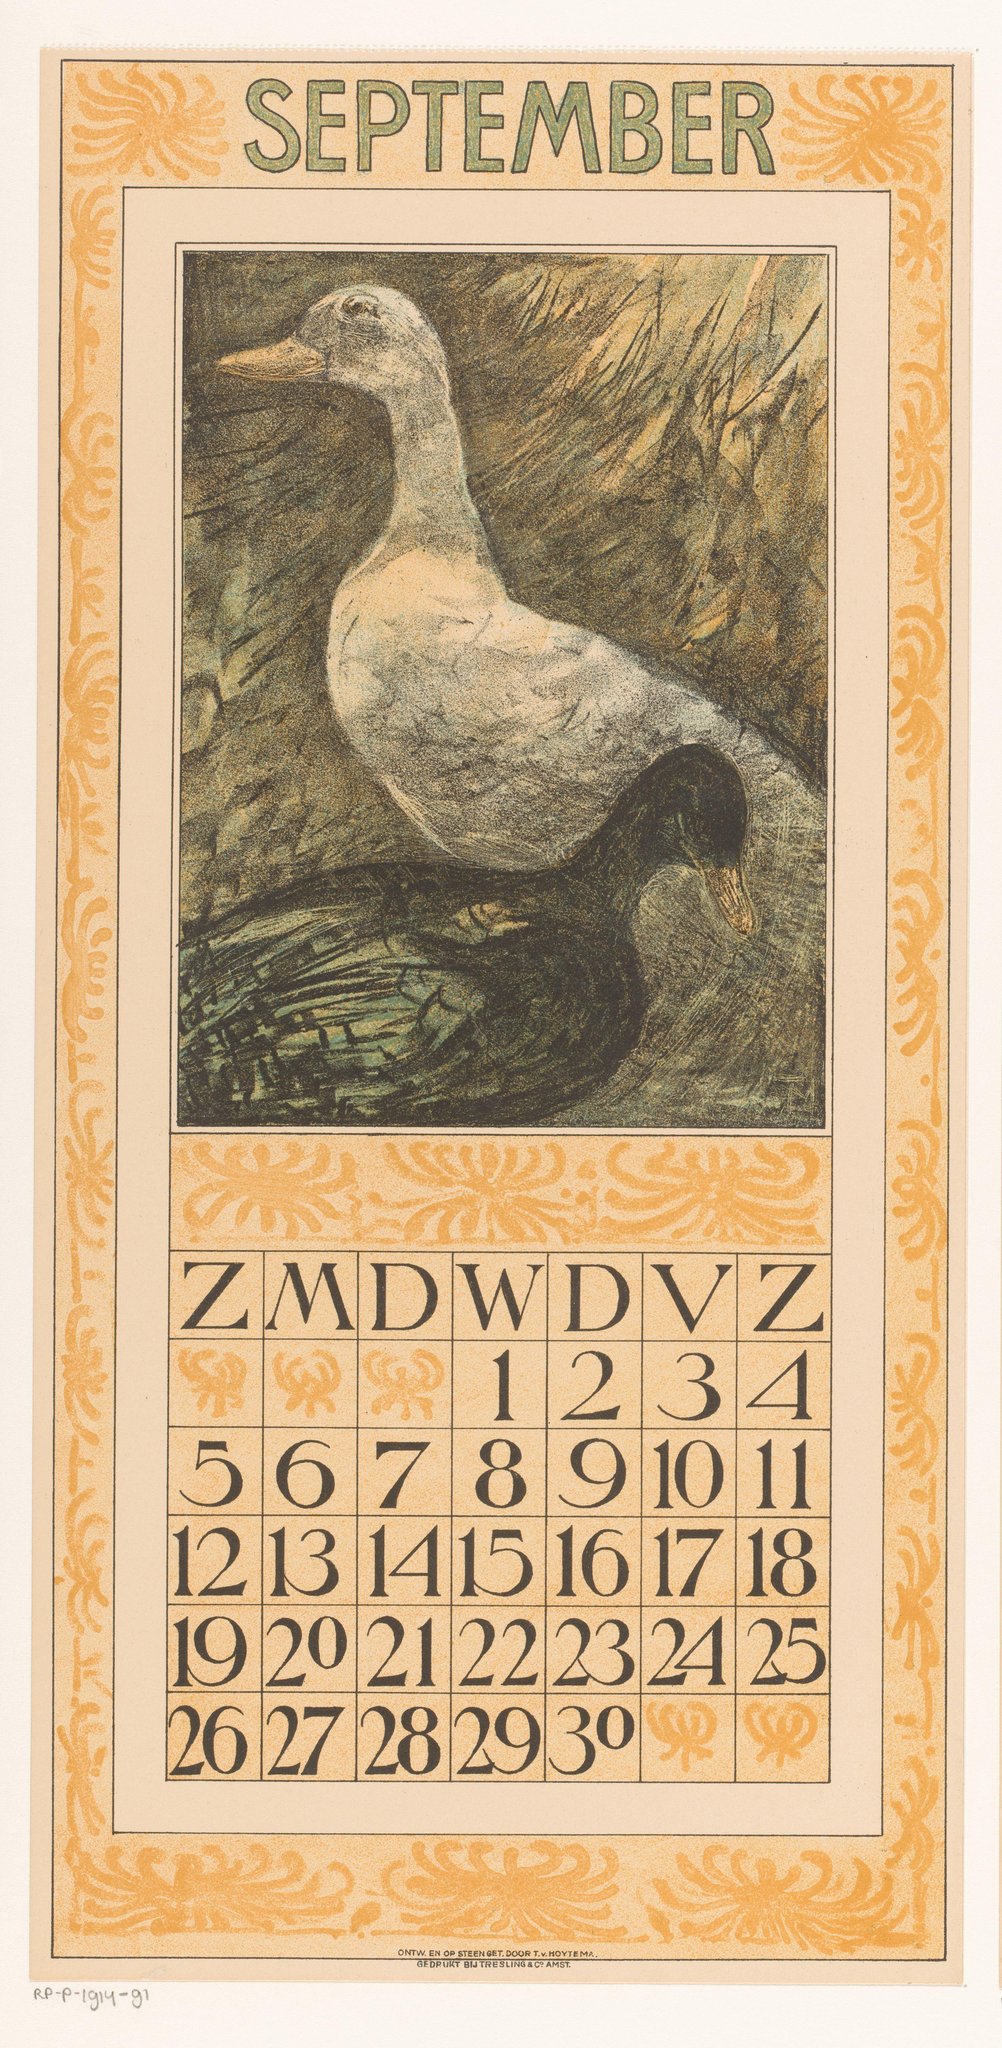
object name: calendar leaf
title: Kalenderblad september met twee staande eenden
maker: theo van hoytema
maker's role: draughtsman, painter, print maker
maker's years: 1863-1917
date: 1908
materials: paper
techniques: lithograph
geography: amsterdam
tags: water-birds: duck, september ~ other concepts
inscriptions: collector's mark: Lugt 2228